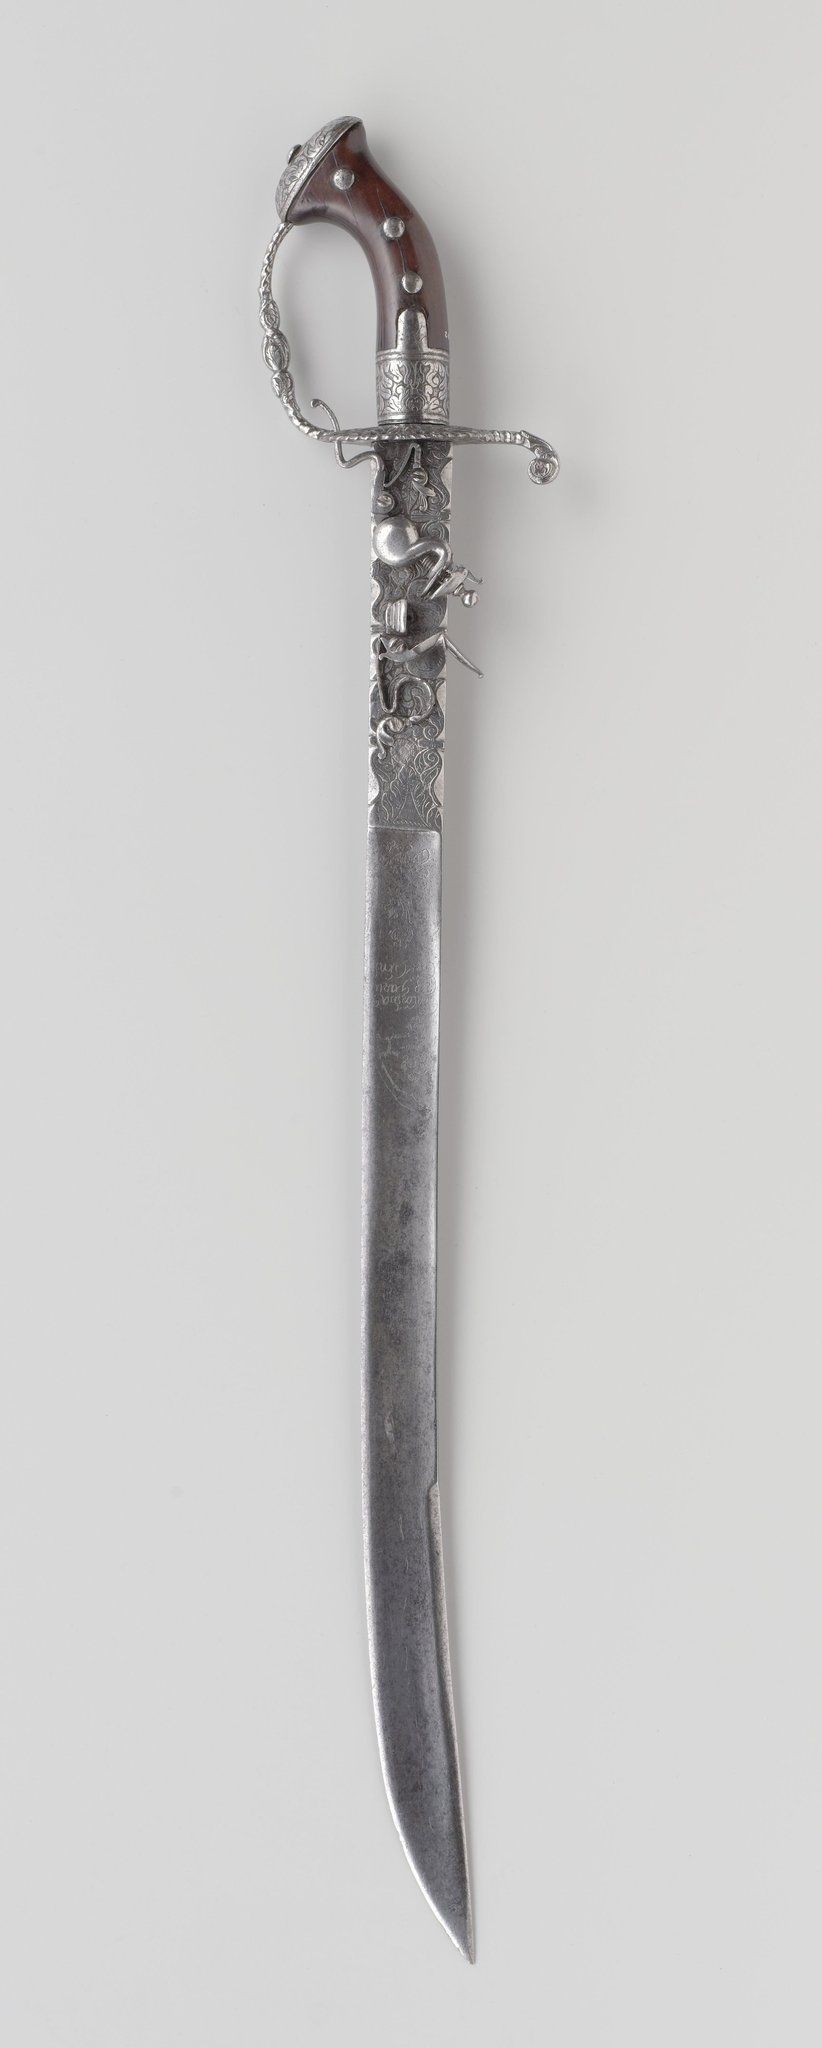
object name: flintlock pistol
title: Houwer met vuursteenpistool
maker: Anonymous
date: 1655-1660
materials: iron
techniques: engraving, sawing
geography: netherlands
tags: netherlands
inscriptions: inscription: ‘Cr[e]dens // Pro nobis // Quis // Consientius’, inscription: ‘Concordia // res Parv[ae] // Cres[-]Cunt’